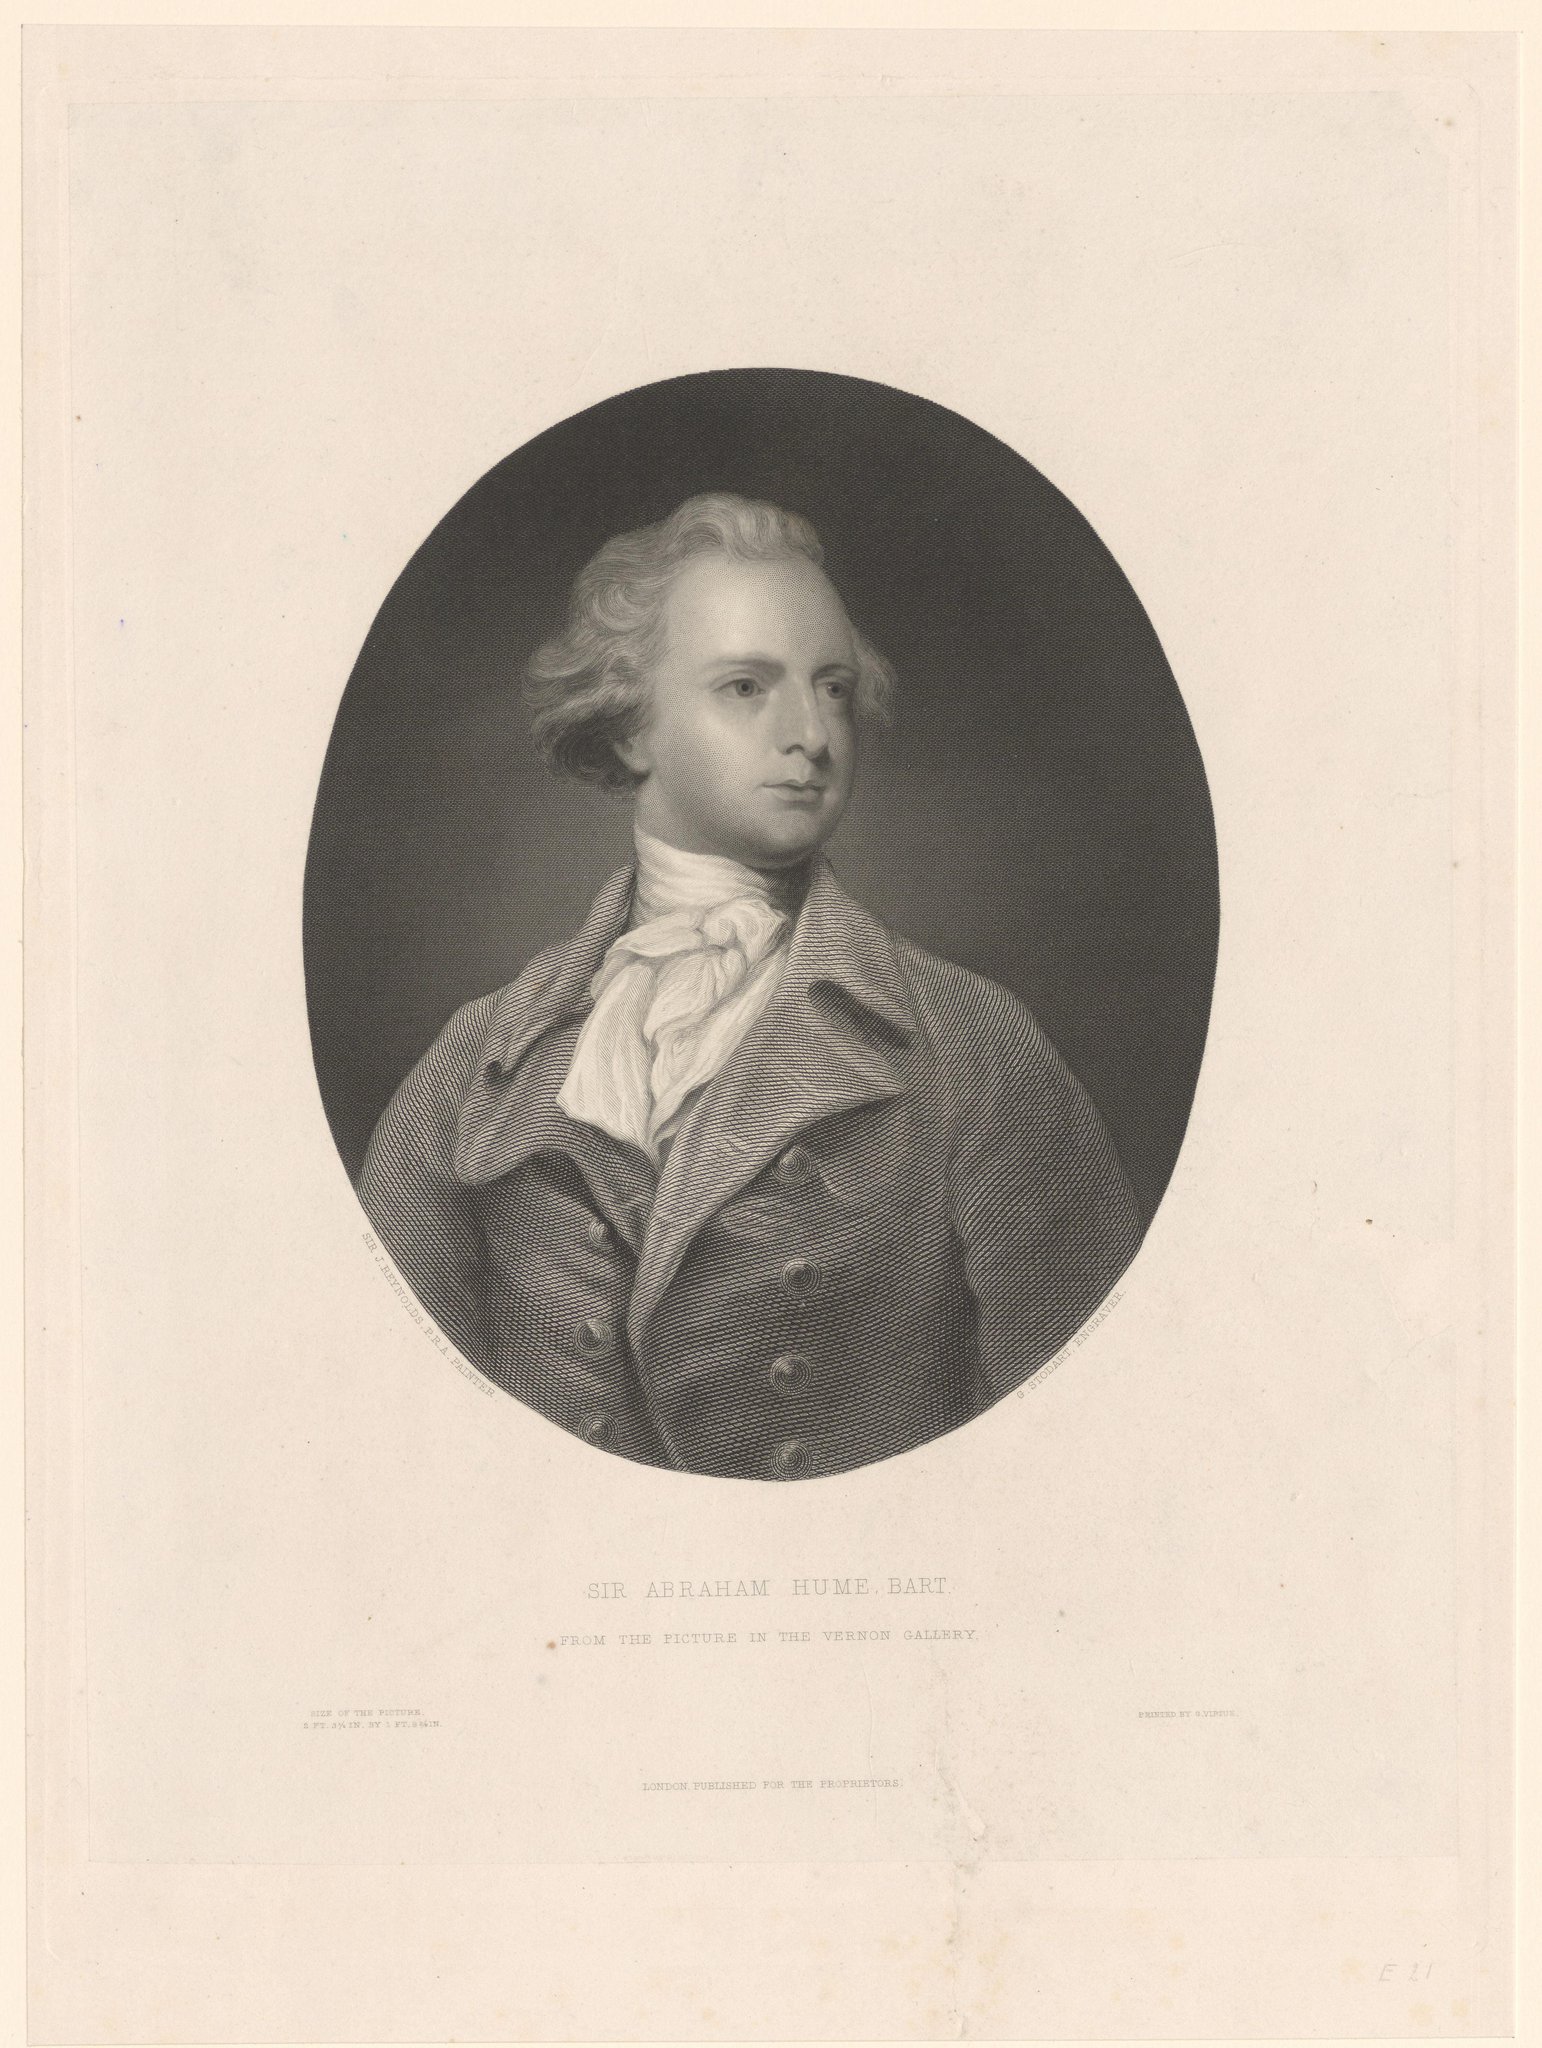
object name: print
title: Portret van Abraham Hume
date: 1854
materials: paper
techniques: engraving, etching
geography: london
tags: painter, politician, abraham hume (2e baronet), historical persons, art collector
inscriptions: collector's mark: Lugt 2228